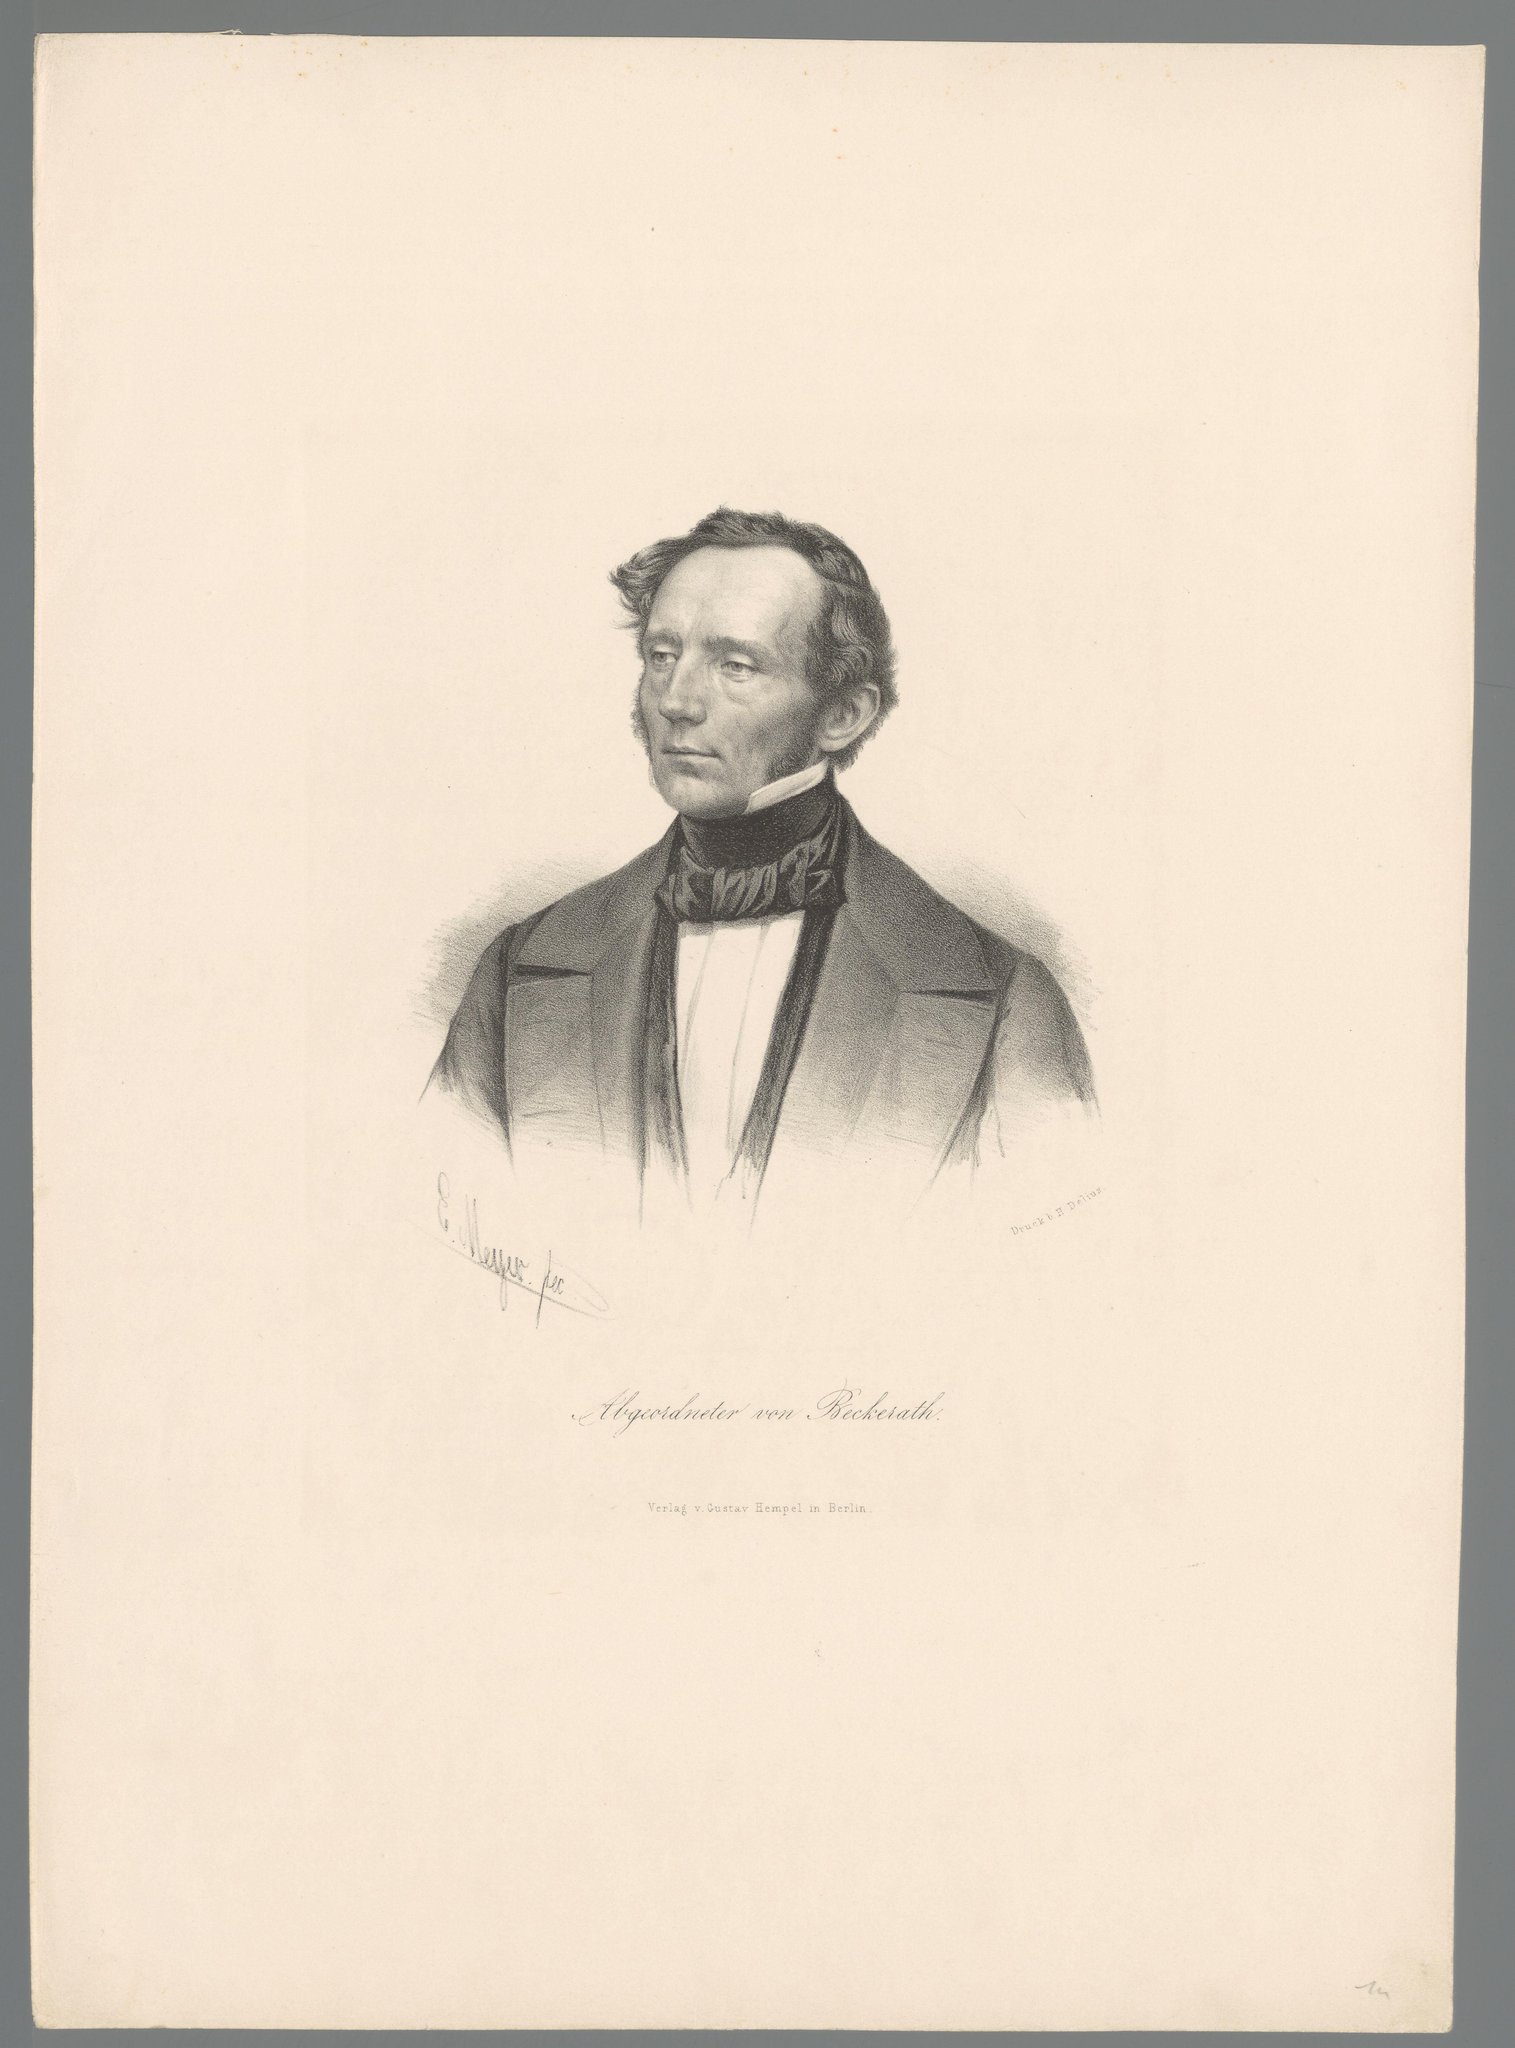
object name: print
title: Abgeordneter von Beckerath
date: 1825-1875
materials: paper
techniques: lithograph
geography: berlin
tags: adult man, historical persons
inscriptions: collector's mark: Lugt 2228